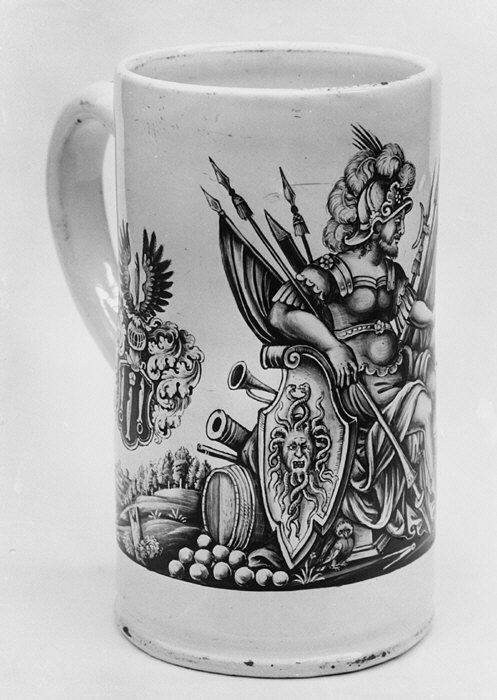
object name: mug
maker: johann ludwig faber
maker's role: decorator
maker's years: 1648-1727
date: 1700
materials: earthenware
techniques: glazing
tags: soldiers,coat of arms